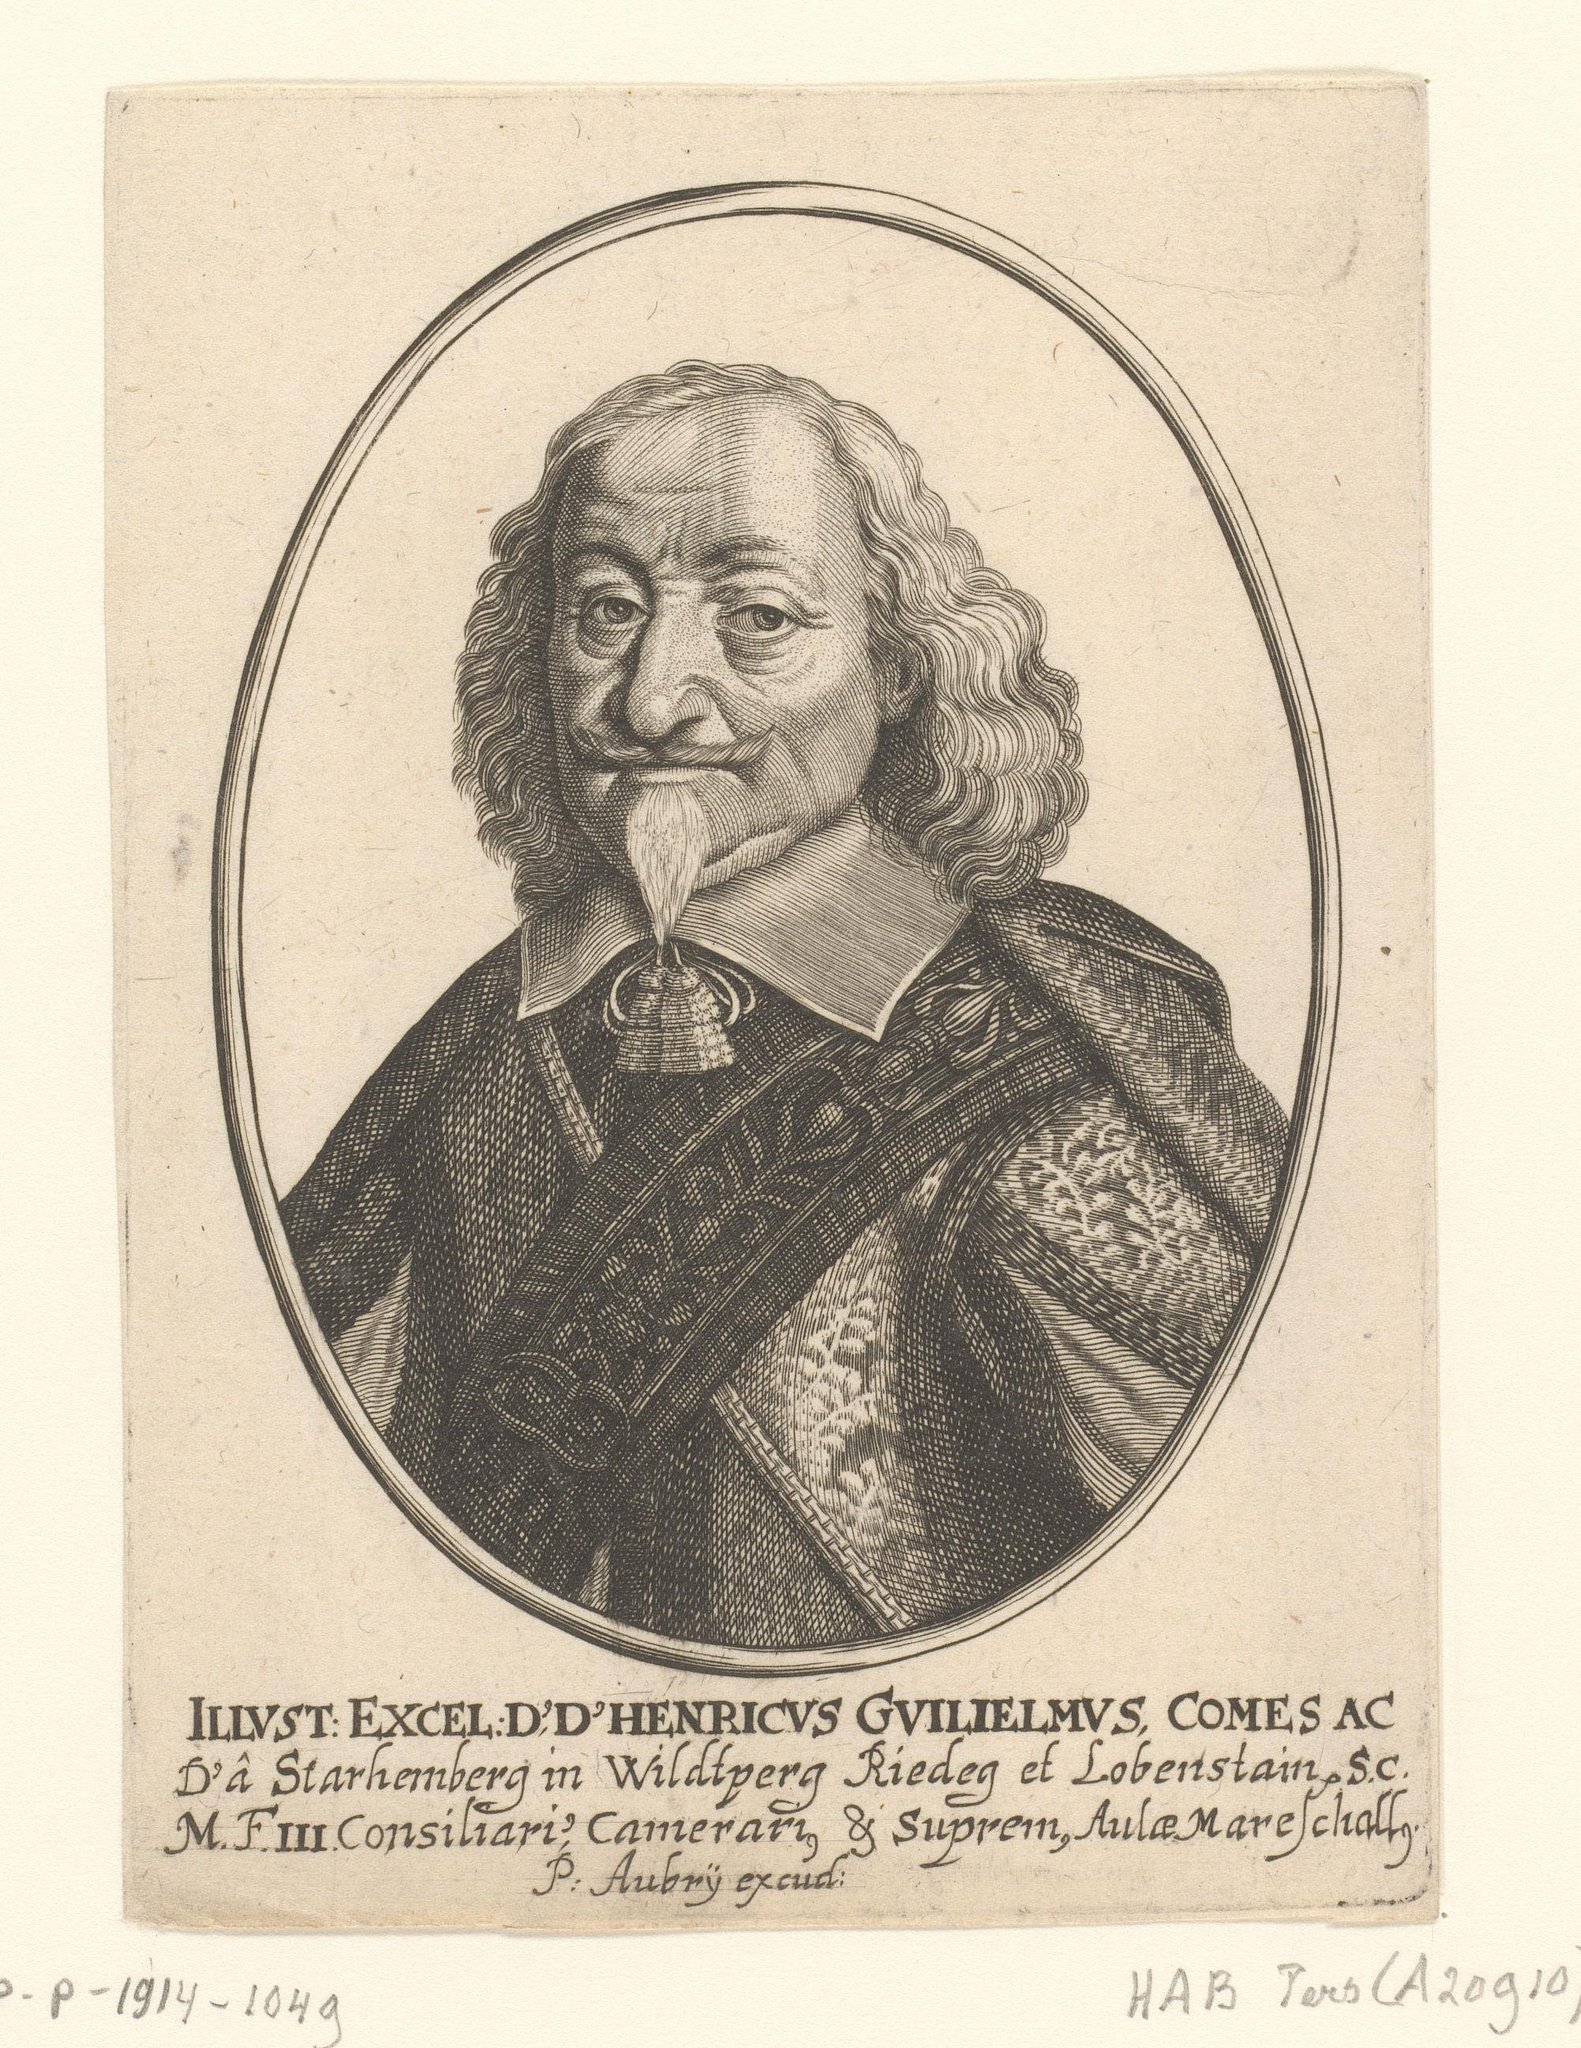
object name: print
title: Portret van Heinrich Wilhelm von Starhemberg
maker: Anonymous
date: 1606-1686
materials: paper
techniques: engraving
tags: vienna, earl, commander-in-chief, general, marshal, historical persons, regent, substitute ruler; viceroy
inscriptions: collector's mark: Lugt 2228